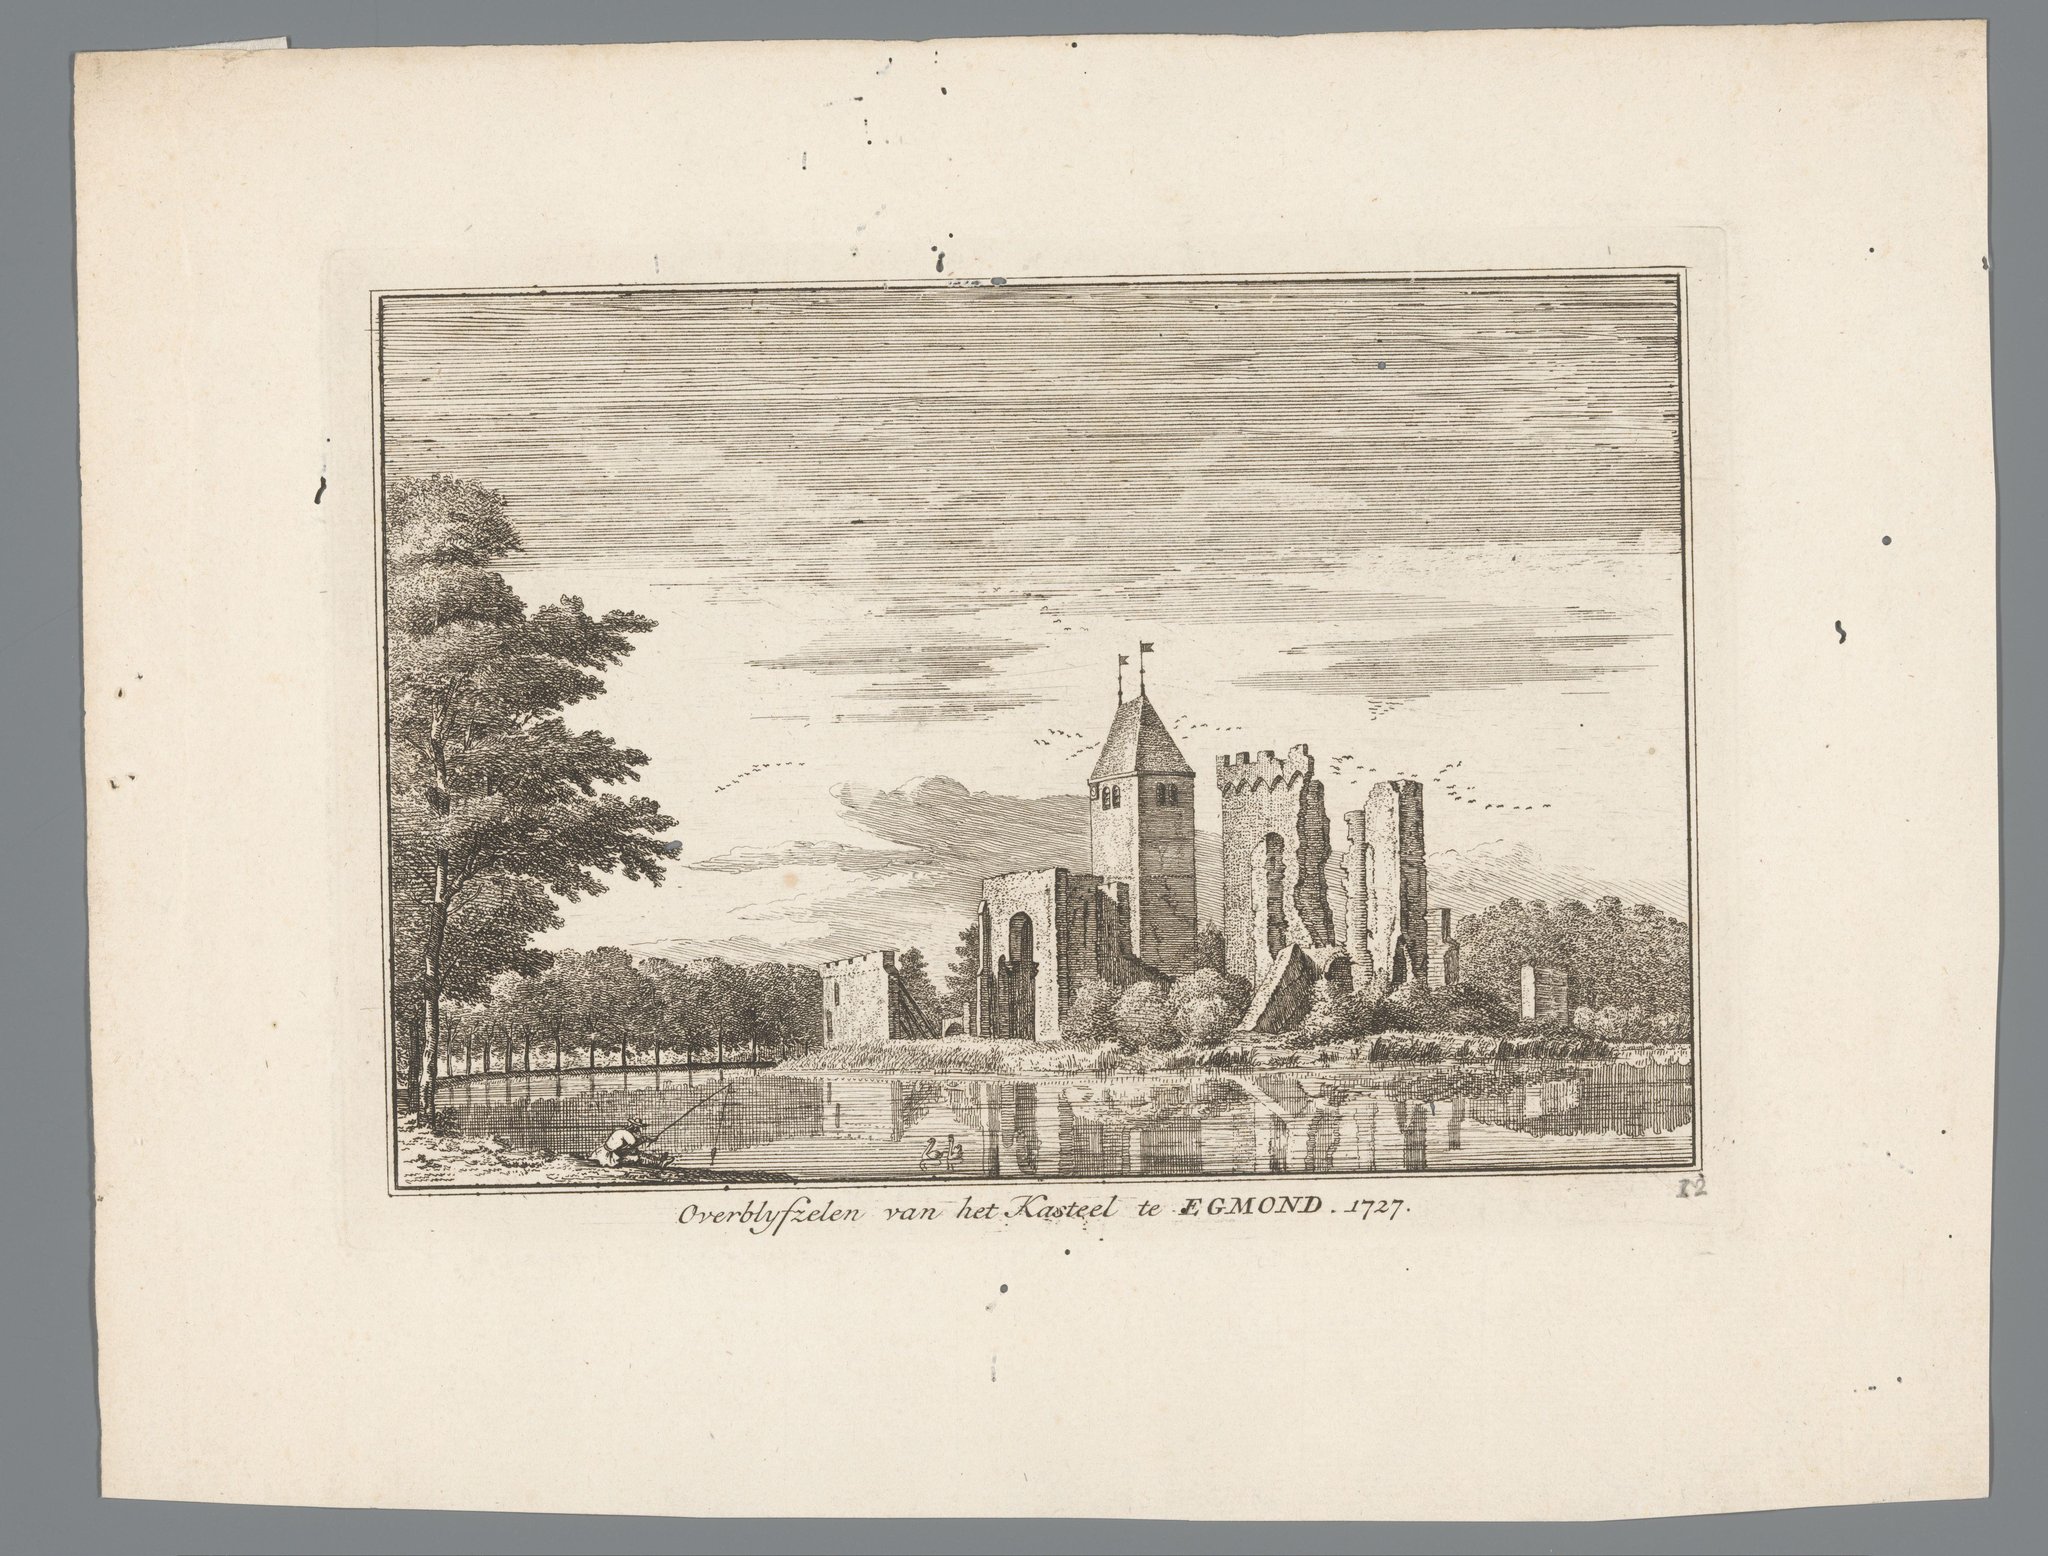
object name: print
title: Gezicht op de ruïnes van Kasteel Egmond, 1727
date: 1739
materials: paper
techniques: etching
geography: haarlem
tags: landscape with ruins, ruin of a dwelling, house, castle, etc.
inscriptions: collector's mark: Lugt 2228, inscription: ‘12’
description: Prent uit: Kennemerlandsche Gezichten. S.l.s.n., 1739. Sommige latere uitgaves van deze serie hebben het adres van Pierre Fouquet in Amsterdam.